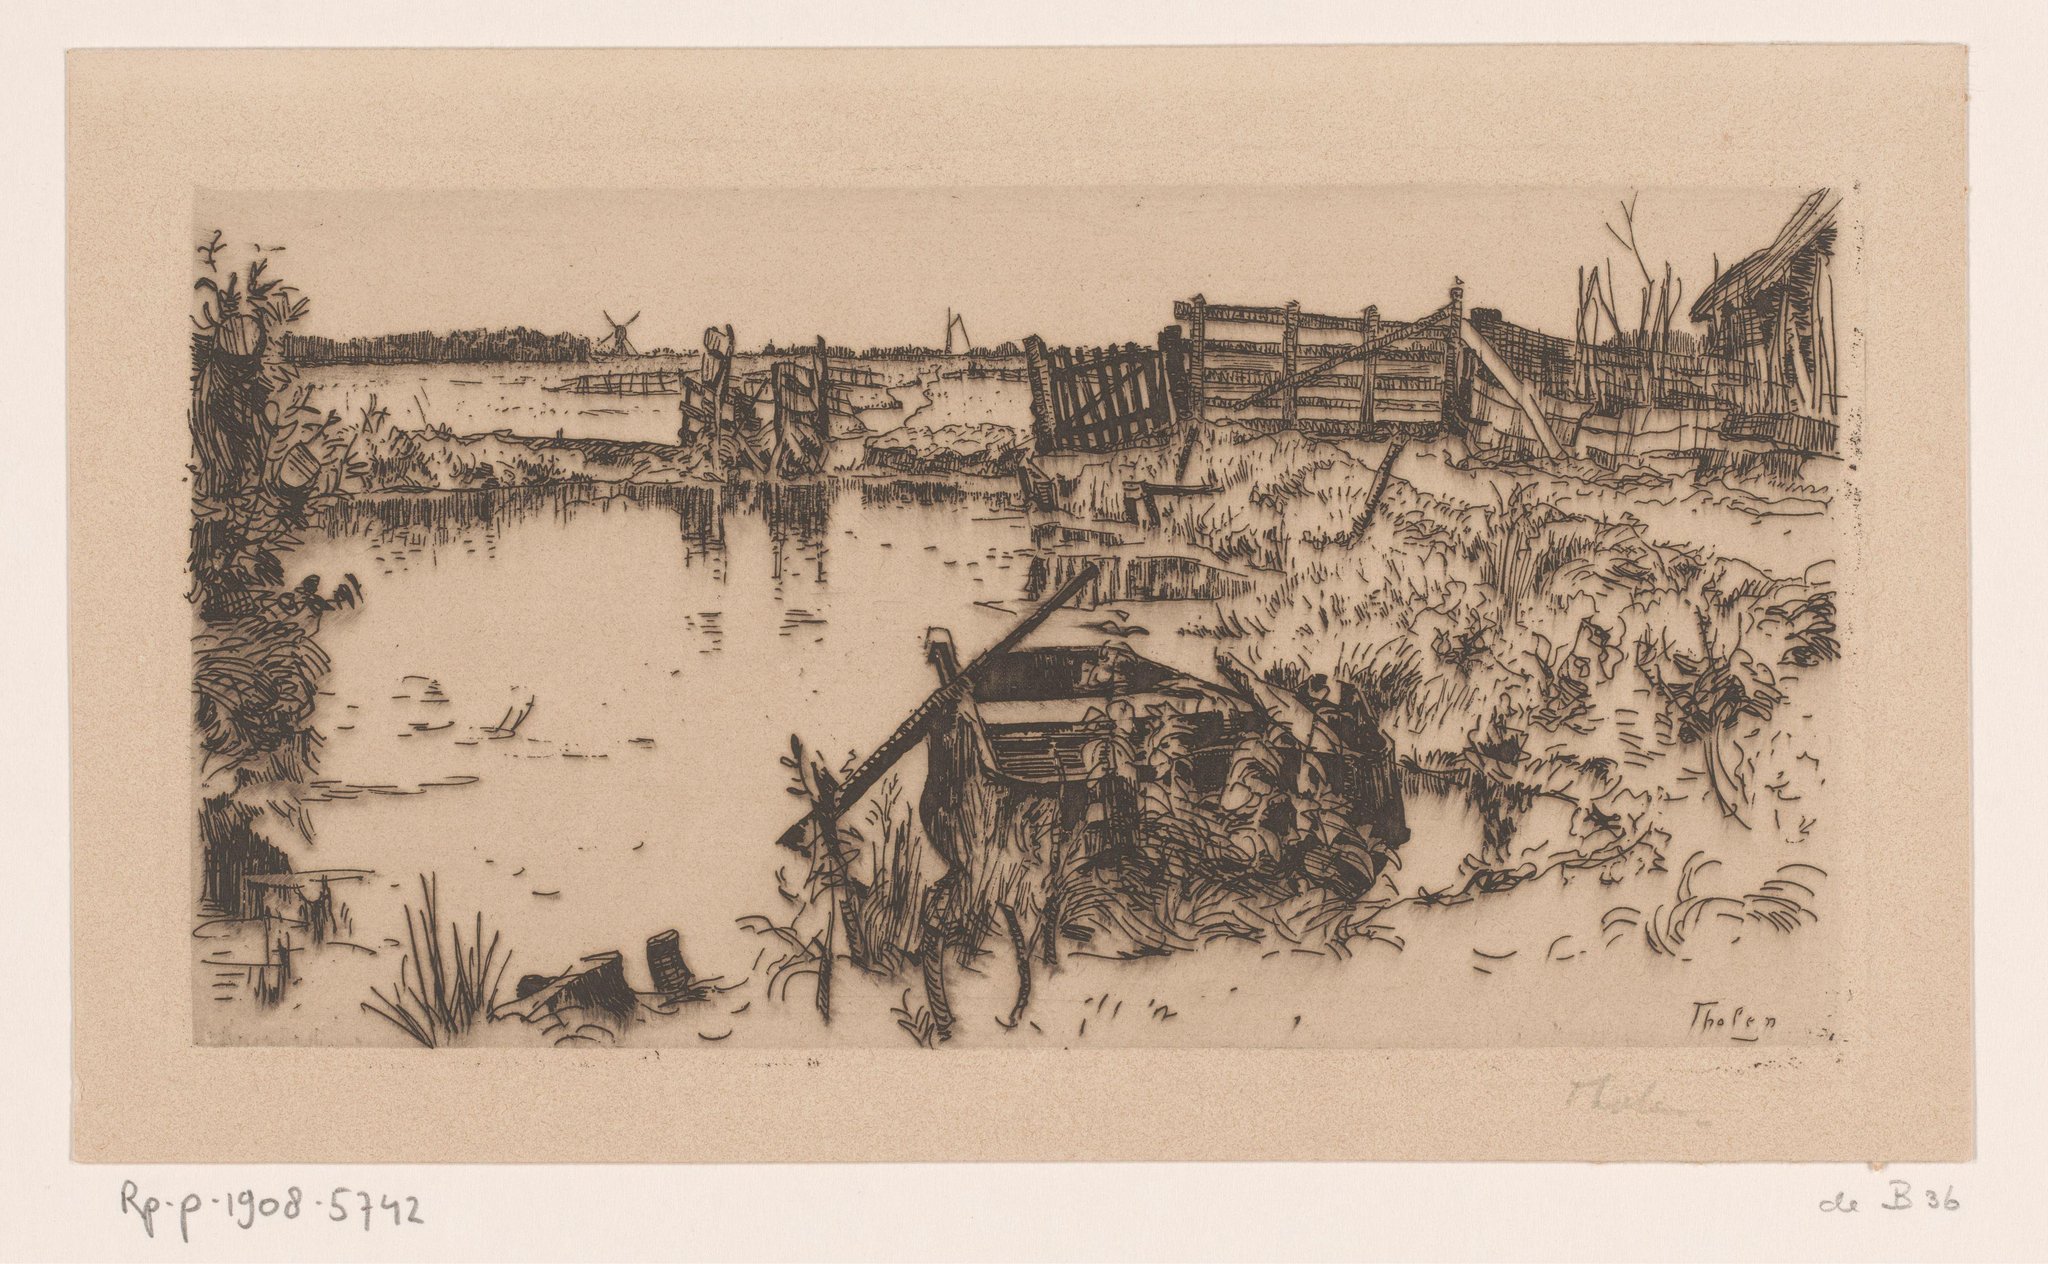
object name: print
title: Polderlandschap met weilanden, sloot en roeiboot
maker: willem bastiaan tholen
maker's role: draughtsman, painter, print maker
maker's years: 1860-1931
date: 1870-1908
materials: paper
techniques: etching, intaglio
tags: rowing-boat, canoe, etc., small canal, ditch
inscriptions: collector's mark: Lugt 2228